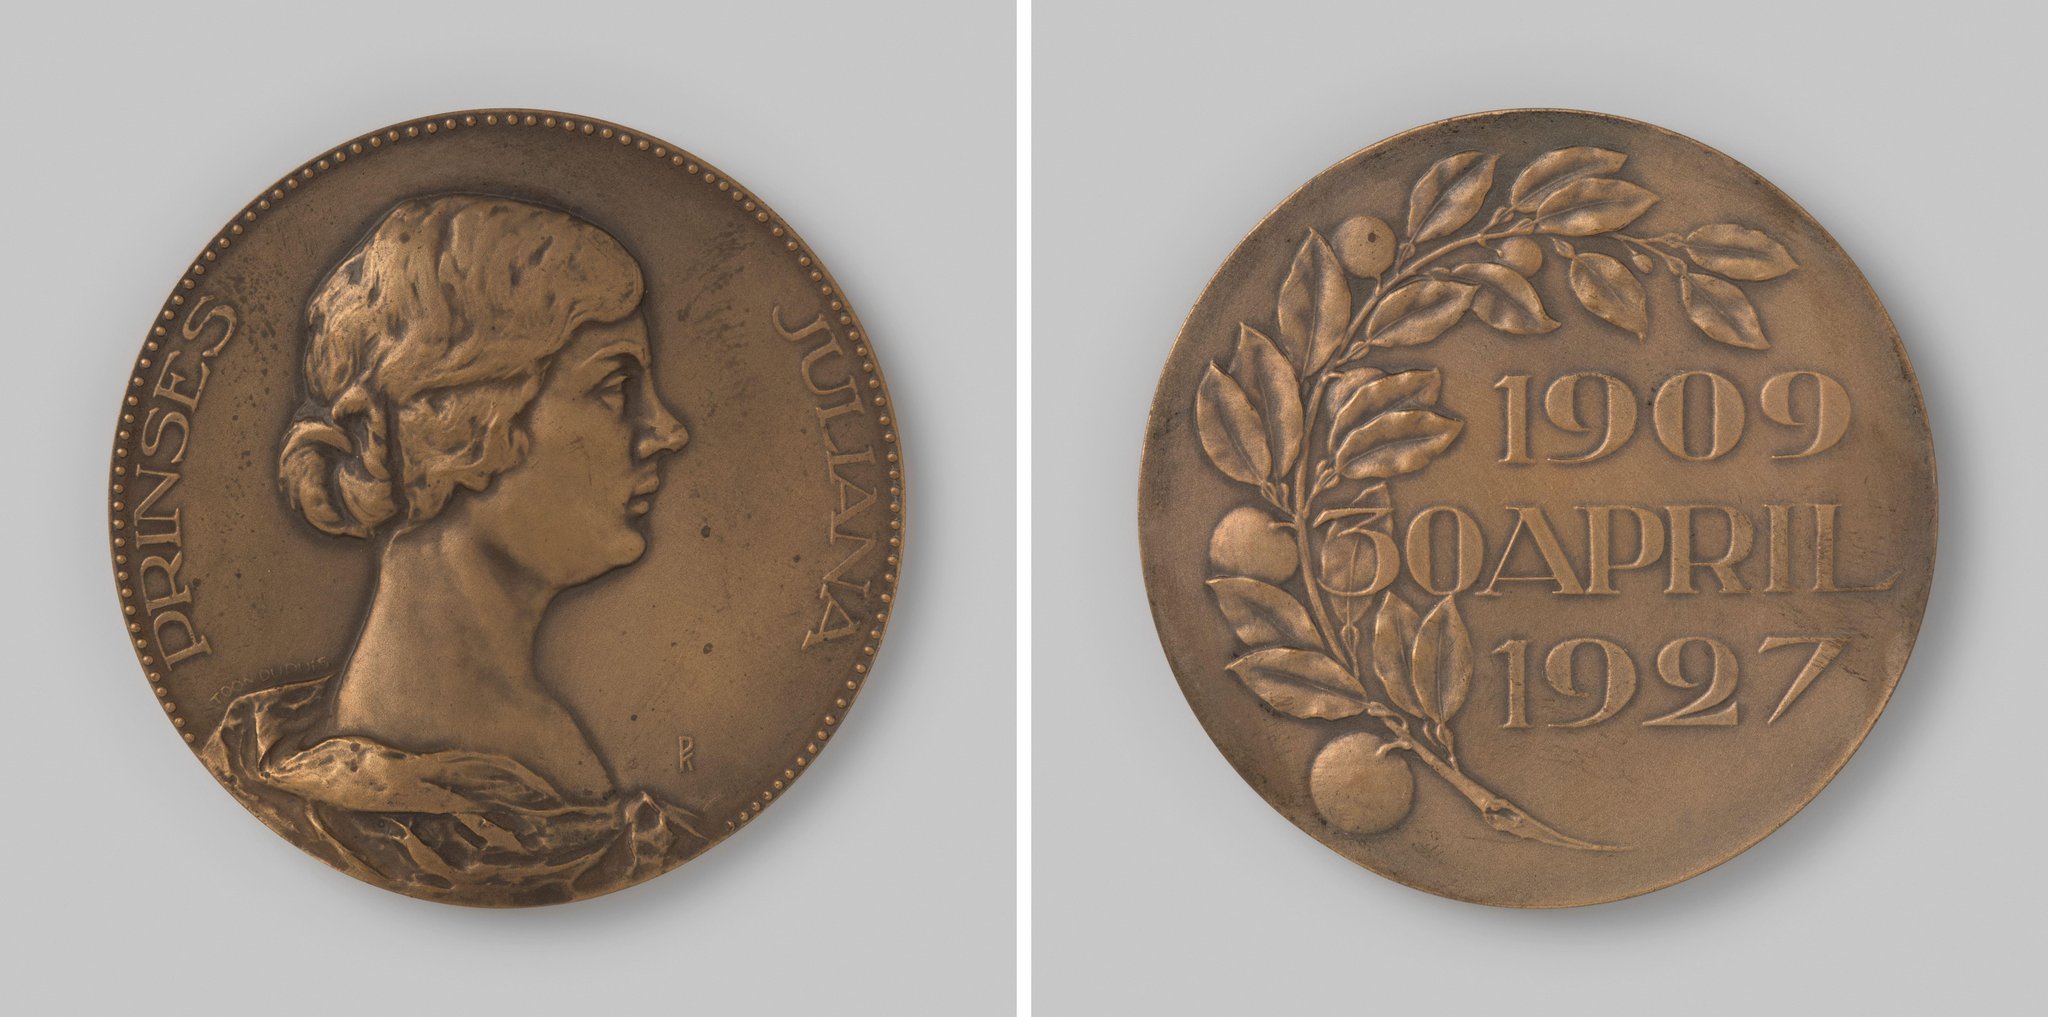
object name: history medal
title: Achttiende verjaardag van prinses Juliana (Vereniging voor Penningkunst 1927, eerste penning)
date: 1927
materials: bronze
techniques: striking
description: Bronzen penning, op de voorzijde het borstbeeld van Juliana naar rechts met omschrift, op de keerzijde drie regels tekst rechts van een halfronde oranjetak, met verklaring.